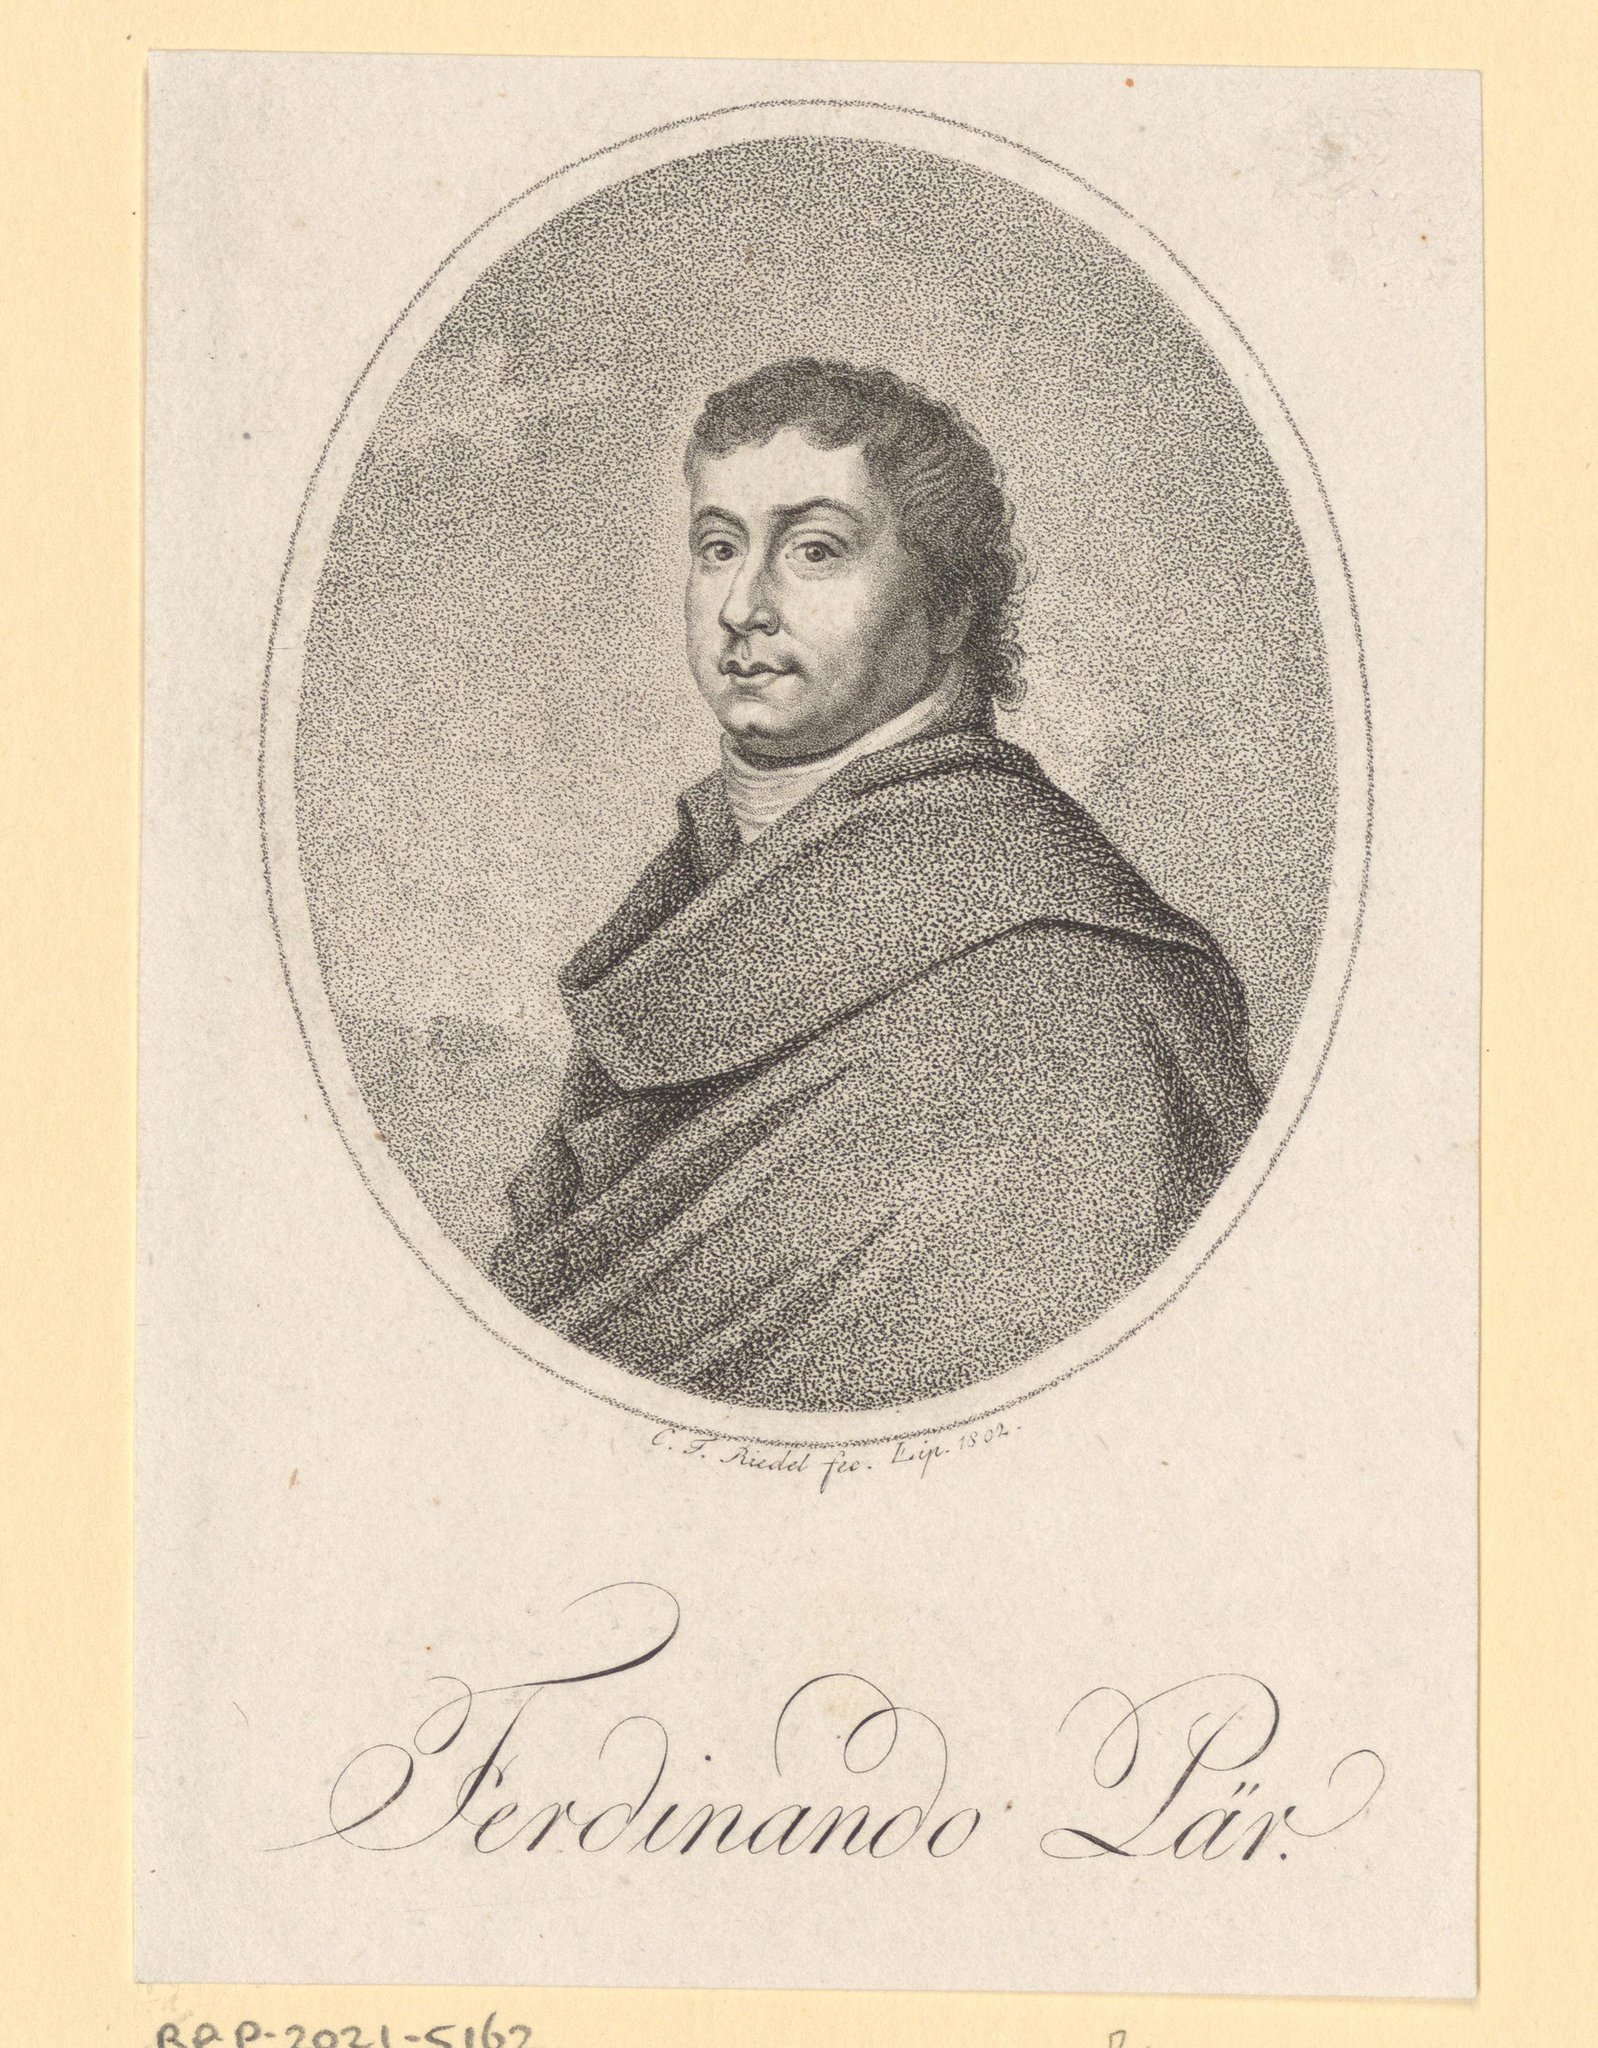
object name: print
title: Portret van Ferdinando Paër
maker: karl traugott riedel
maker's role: print maker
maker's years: 1769-1832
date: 1802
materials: paper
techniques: engraving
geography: leipzig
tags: adult man, historical persons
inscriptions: date